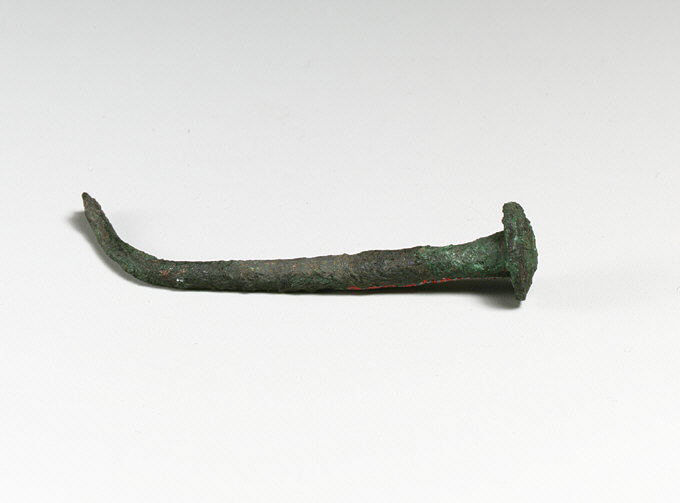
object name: nail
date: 7000 BCE-330 CE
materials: bronze